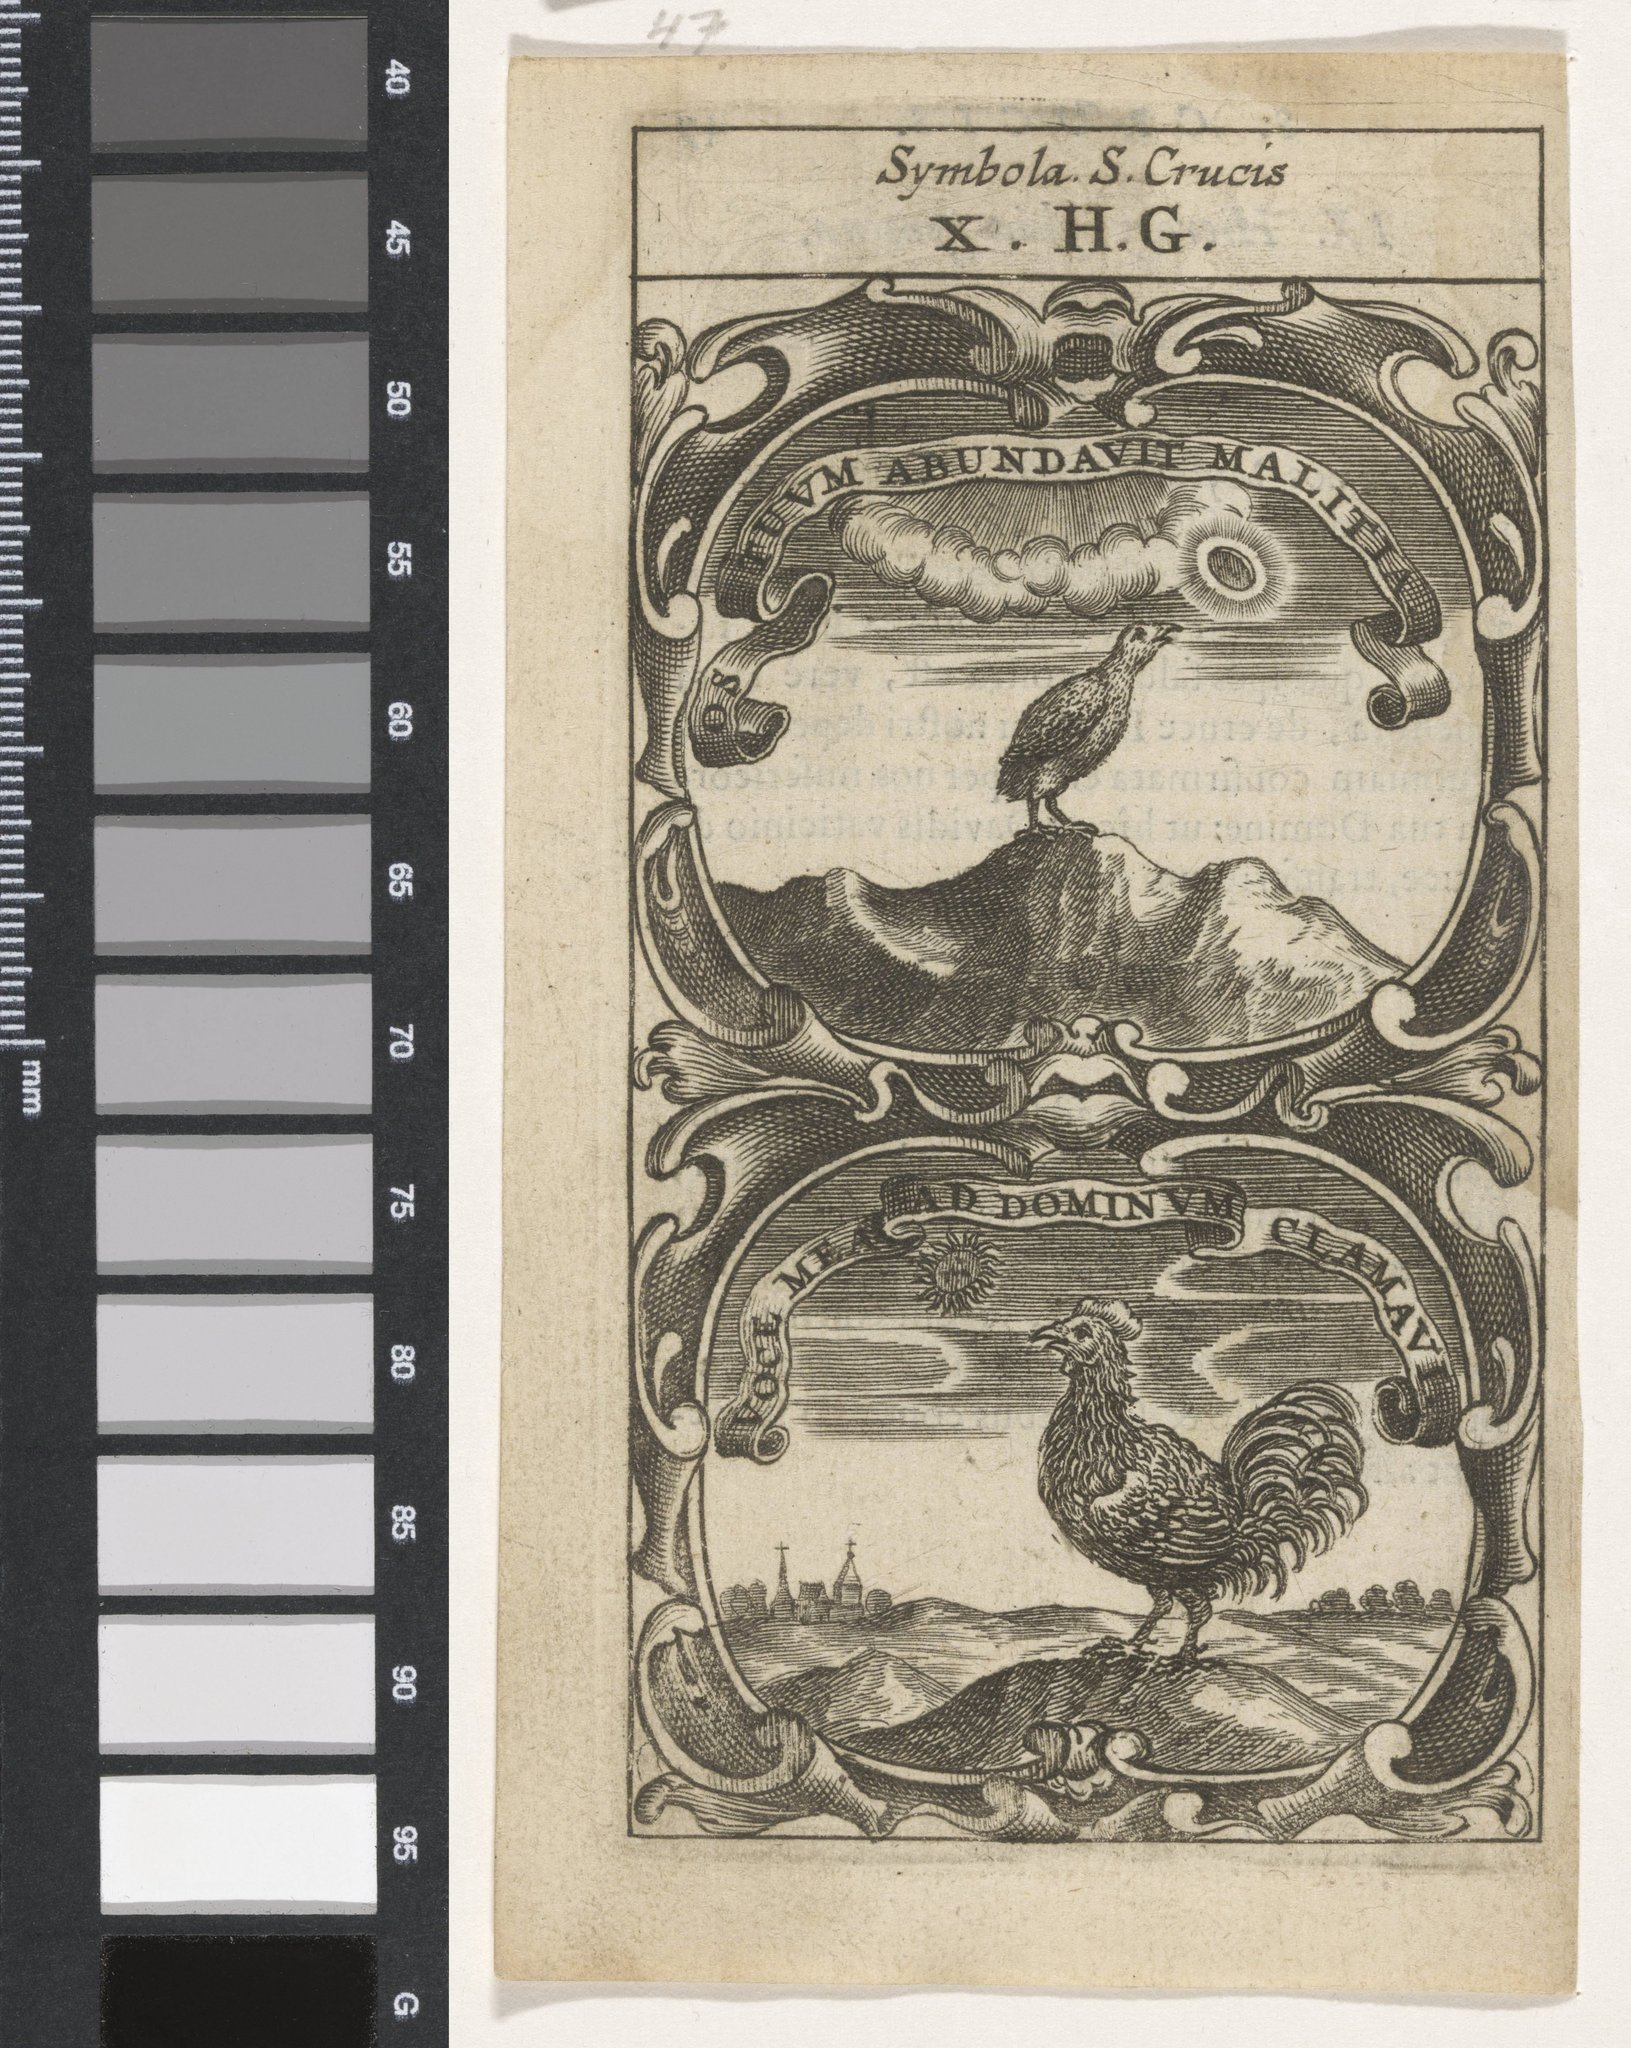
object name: print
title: Tsjilpend vogelkuiken / Kraaiende haan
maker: Anonymous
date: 1666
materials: paper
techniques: engraving, letterpress printing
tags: birds, sun as celestial body, fowl (cock, hen, chicken, etc.)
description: Pagina uit Jacob Typotius, Symbola Divina & Humana Pontificum Imperatorum Regum. Arnhem, J.F. Hagen, 1666 of uit de titeluitgave van 1669 of 1679. Het werk van Typotius werd voor het eerst uitgegeven in 1601 met prenten van Aegidius Sadeler.